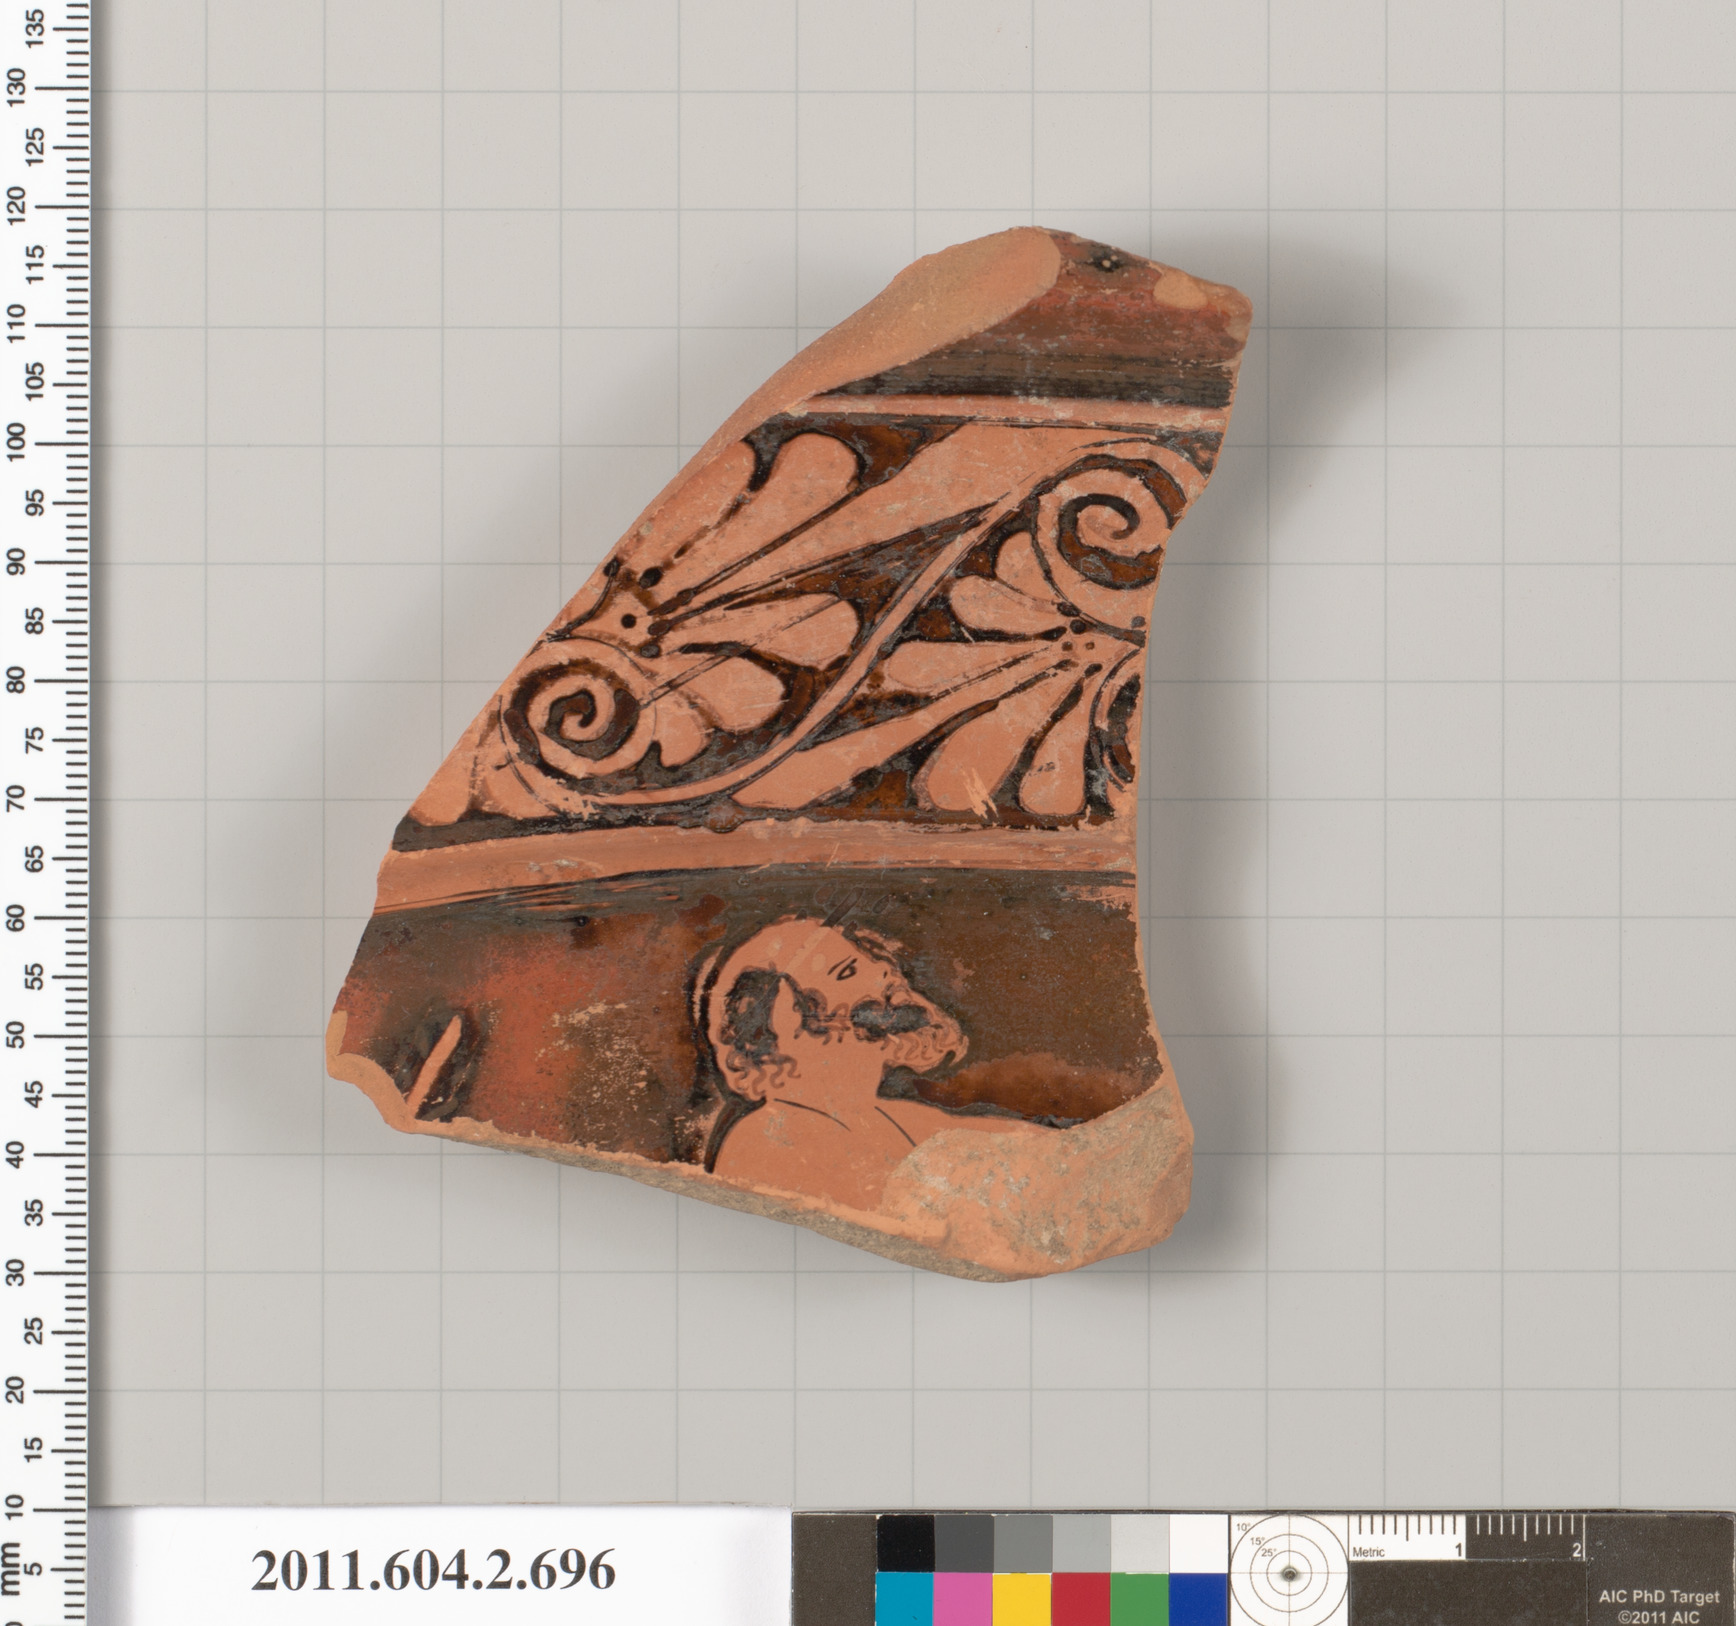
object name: calyx krater fragment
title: Terracotta fragment of a calyx-krater (bowl for mixing wine and water)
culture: greek, attic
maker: phiale painter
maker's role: artist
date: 440-430 BCE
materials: terracotta